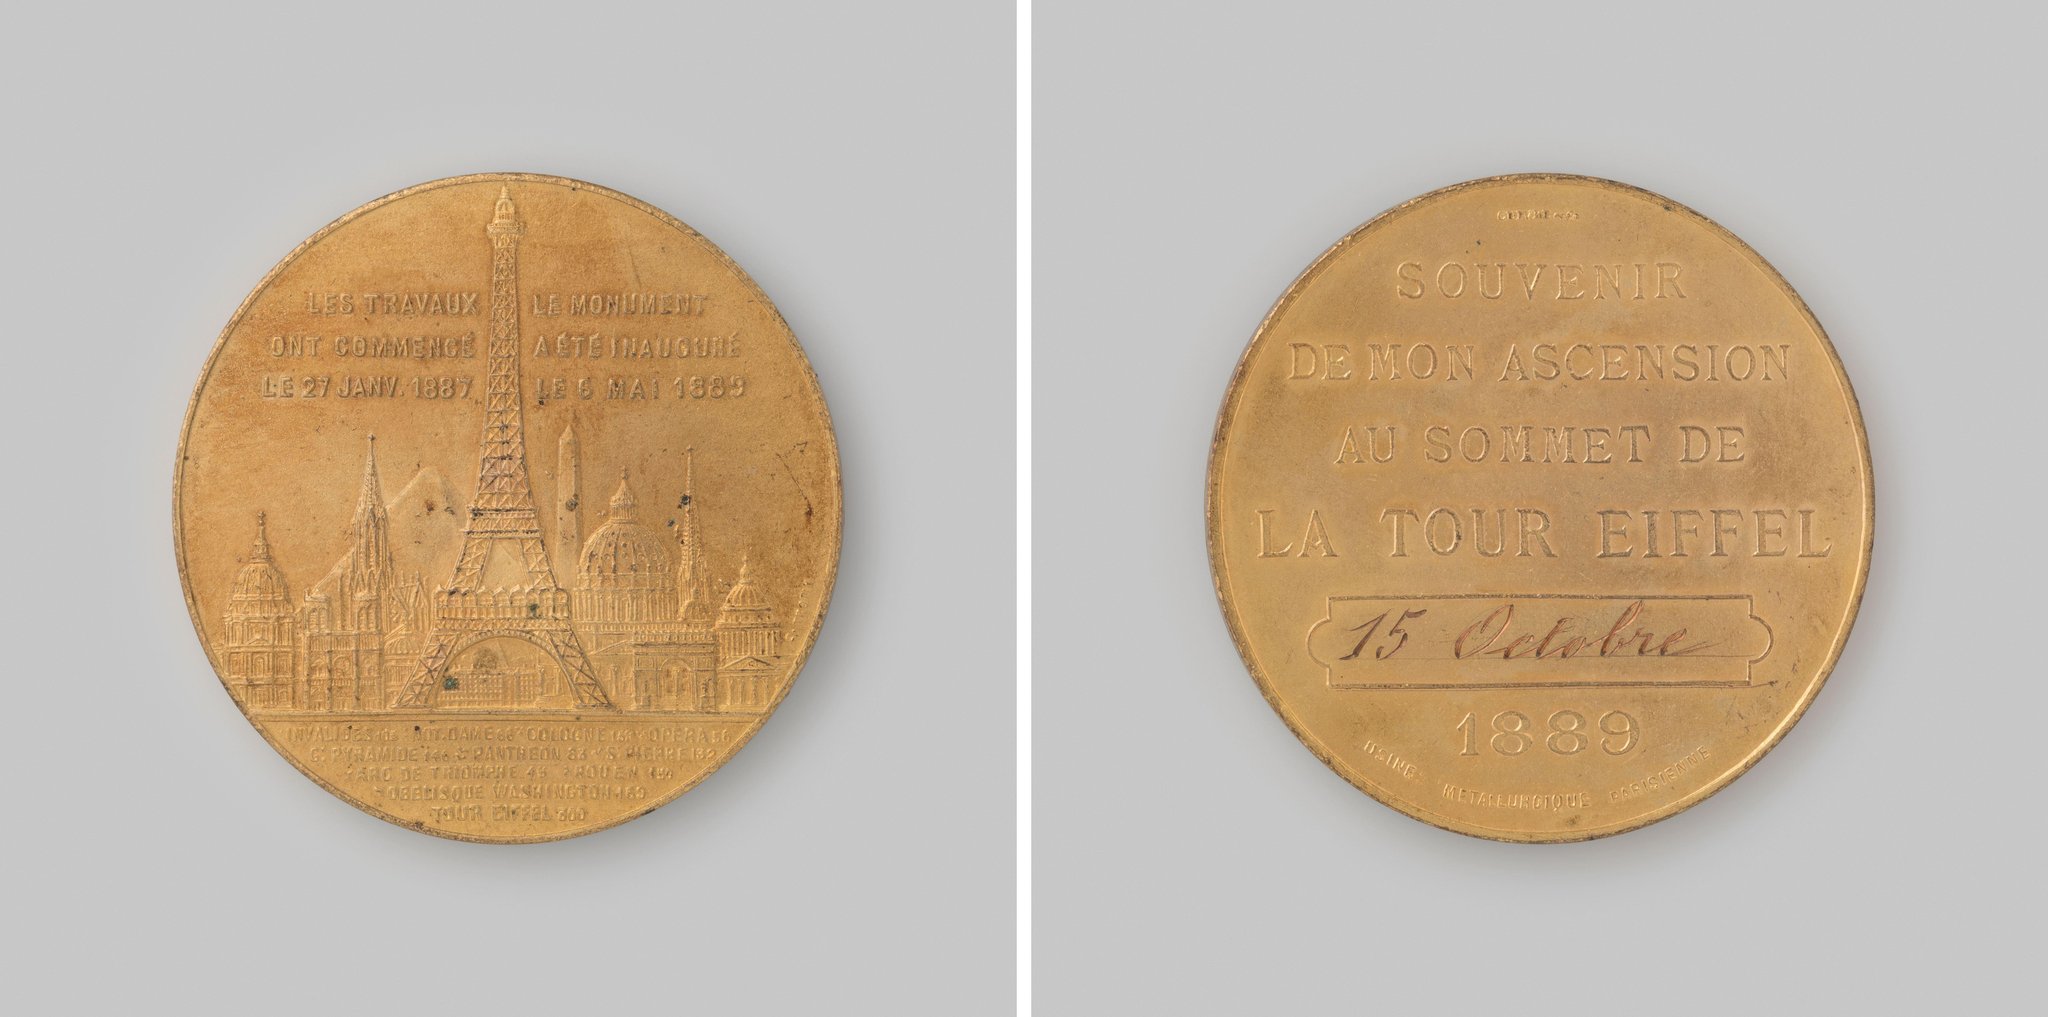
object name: history medal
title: Herinnering aan de beklimming van de Eiffeltoren te Parijs 1889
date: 1889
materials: copper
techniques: striking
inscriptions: inscription: ‘15 Octobre’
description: Vergulde penning, op de voorzijde de Eiffeltoren te midden van andere grote gebouwen, met drie regels tekst en afsnedetekst, op de keerzijde vijf regels tekst en een rechthoekige inscriptieruimte met gegraveerde dagtekening.